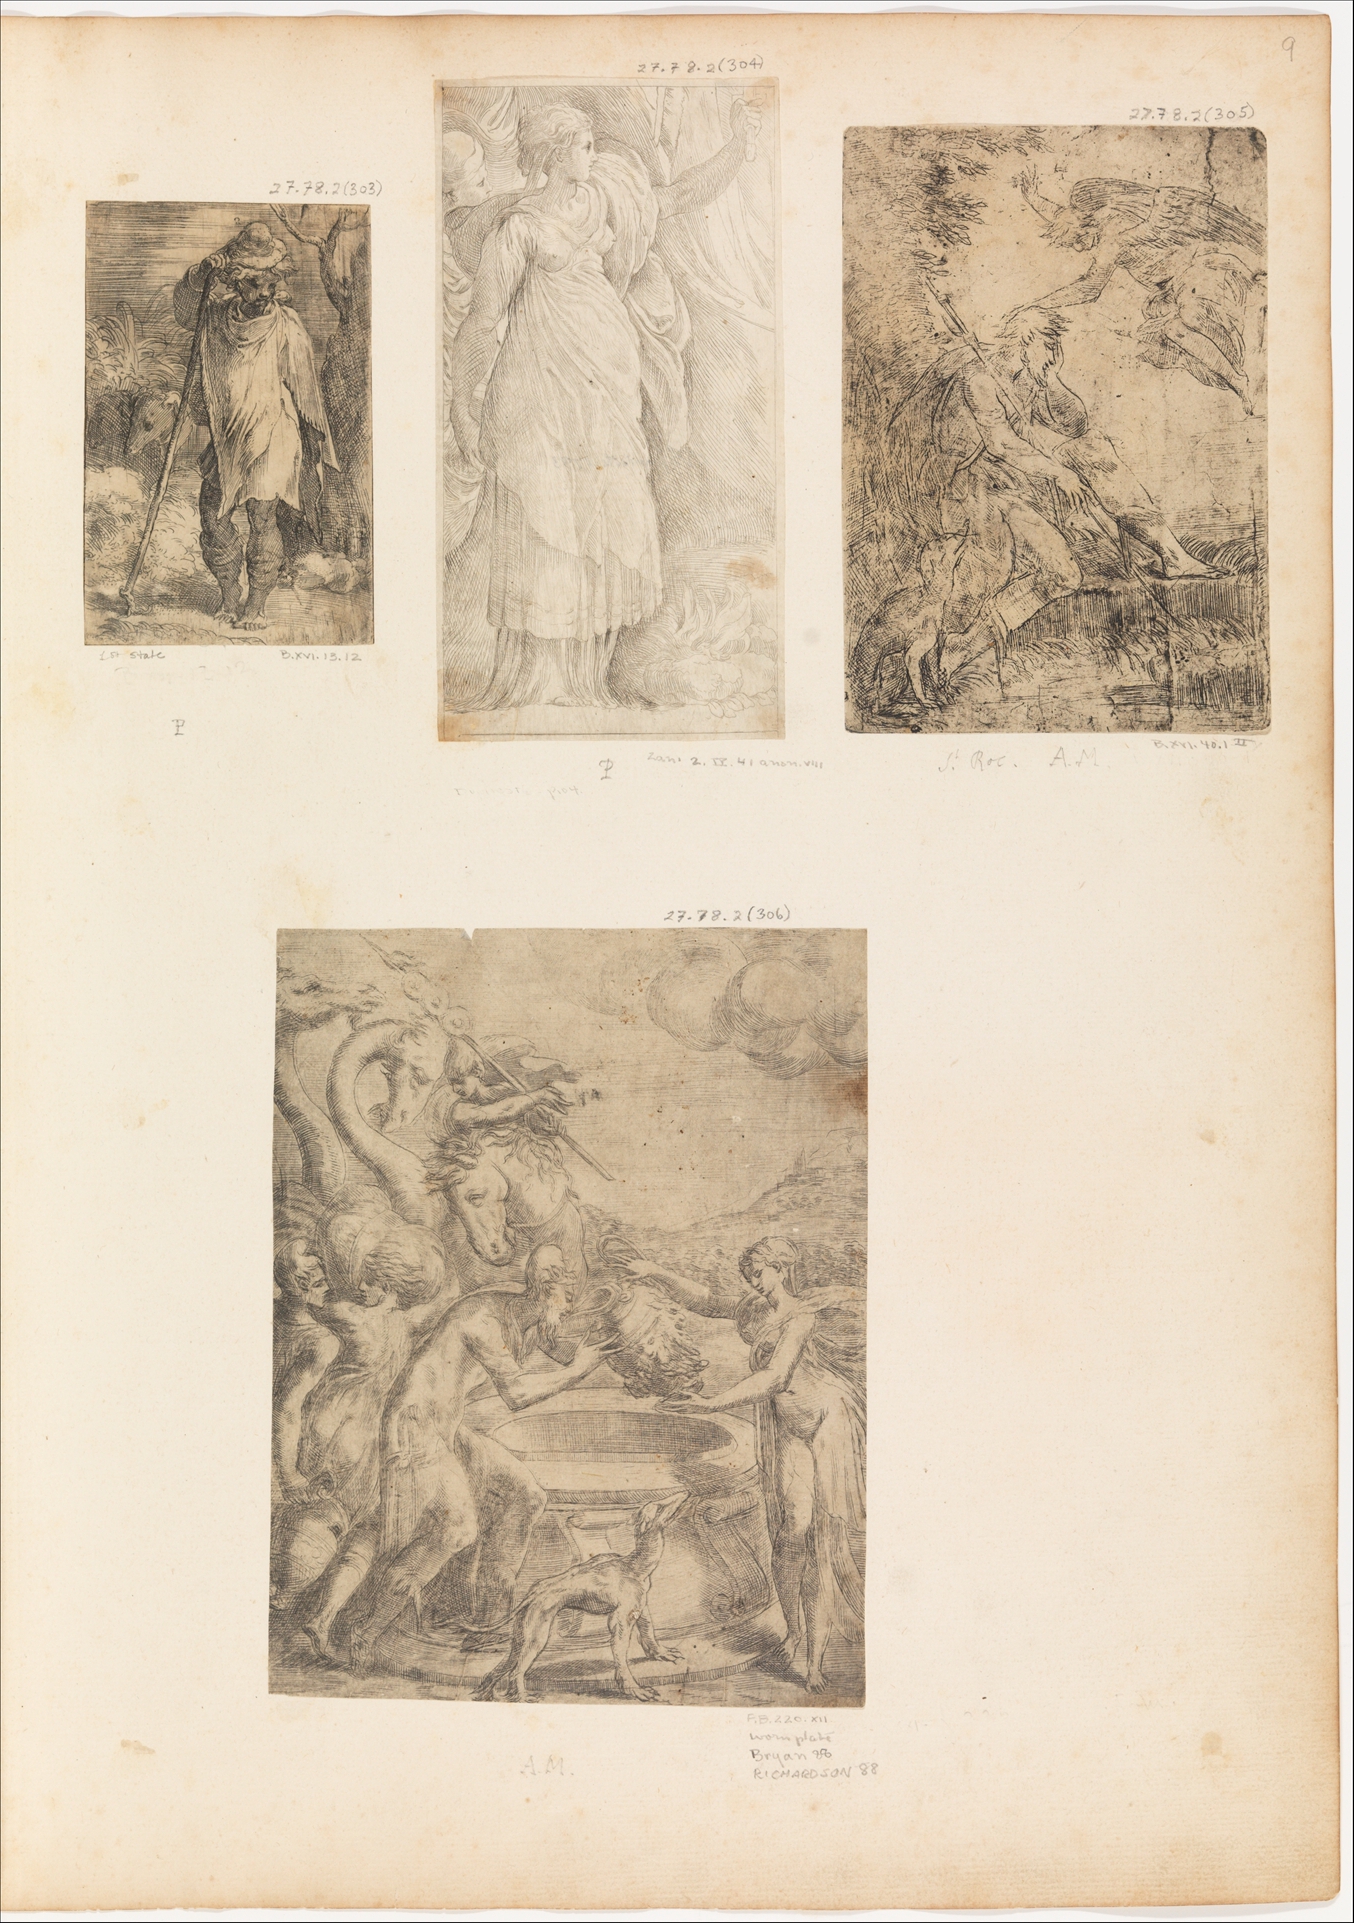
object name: print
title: Rebecca and Eleazer at the Well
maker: andrea schiavone (andrea meldola)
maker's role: artist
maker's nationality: italian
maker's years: 1510-1563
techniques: etching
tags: wells,men,women